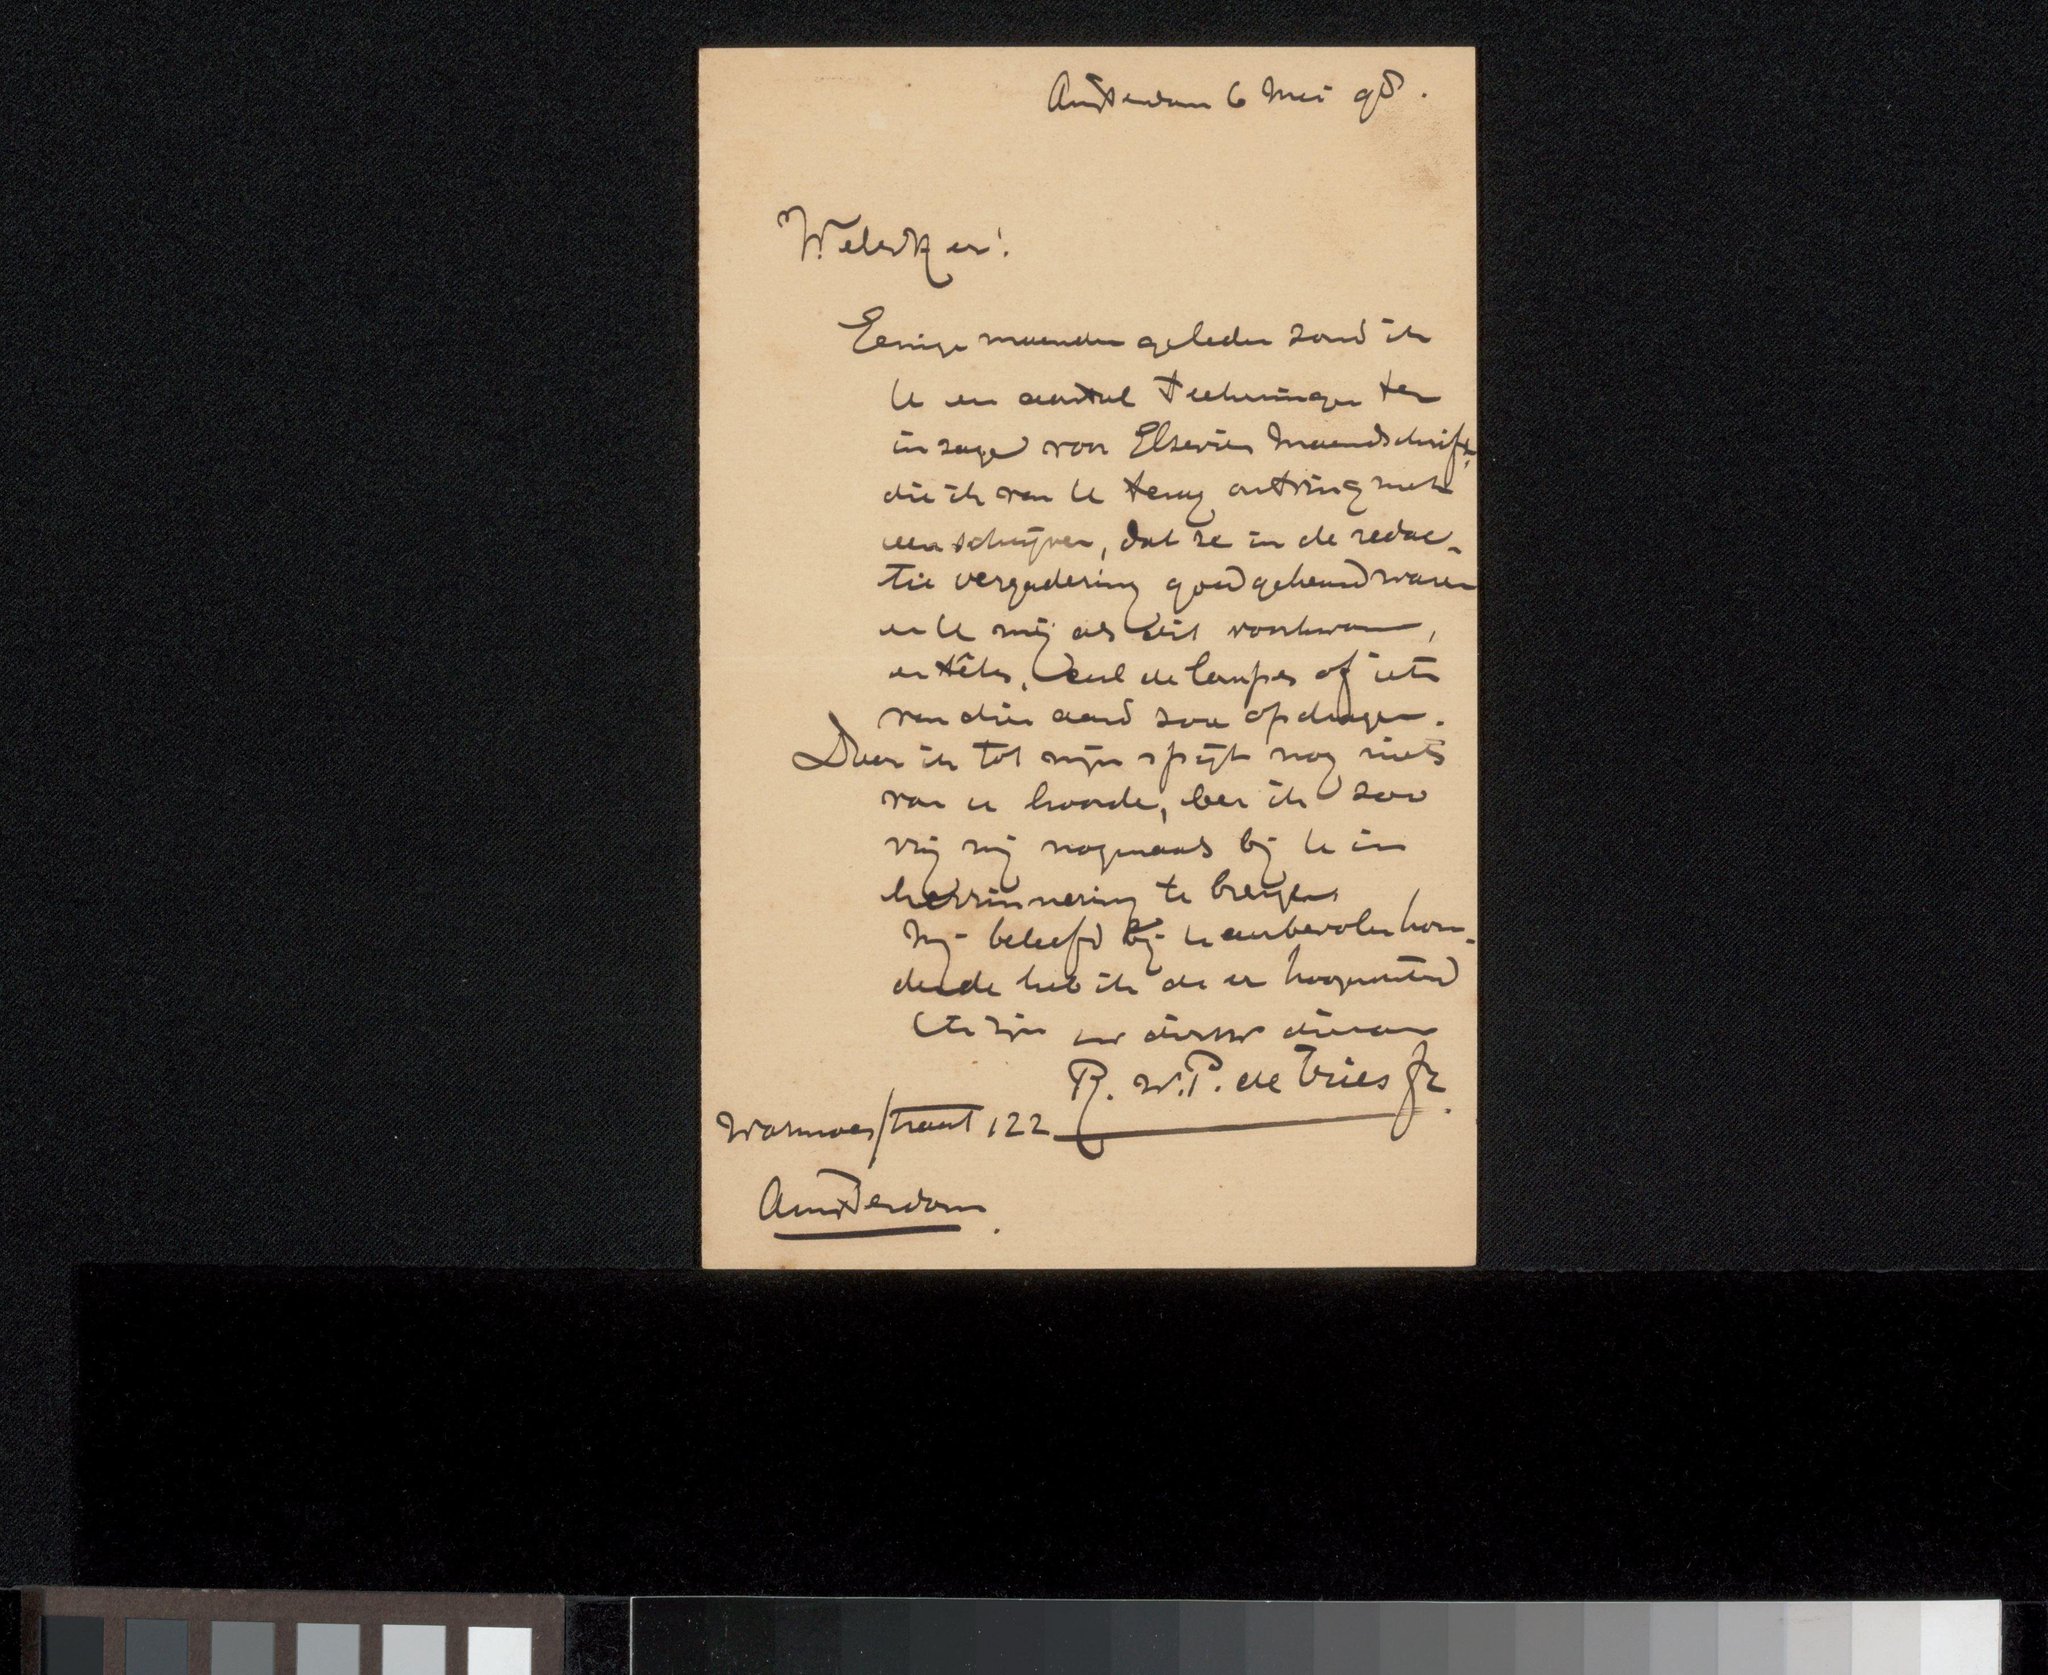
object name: letter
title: Brief aan Philip Zilcken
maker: reinier willem petrus de vries (1874-1953)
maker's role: draughtsman, print maker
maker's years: 1874-1953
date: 1898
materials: ink, paper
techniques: pen, writing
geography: amsterdam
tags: the hague, painter, philip zilcken, drawing